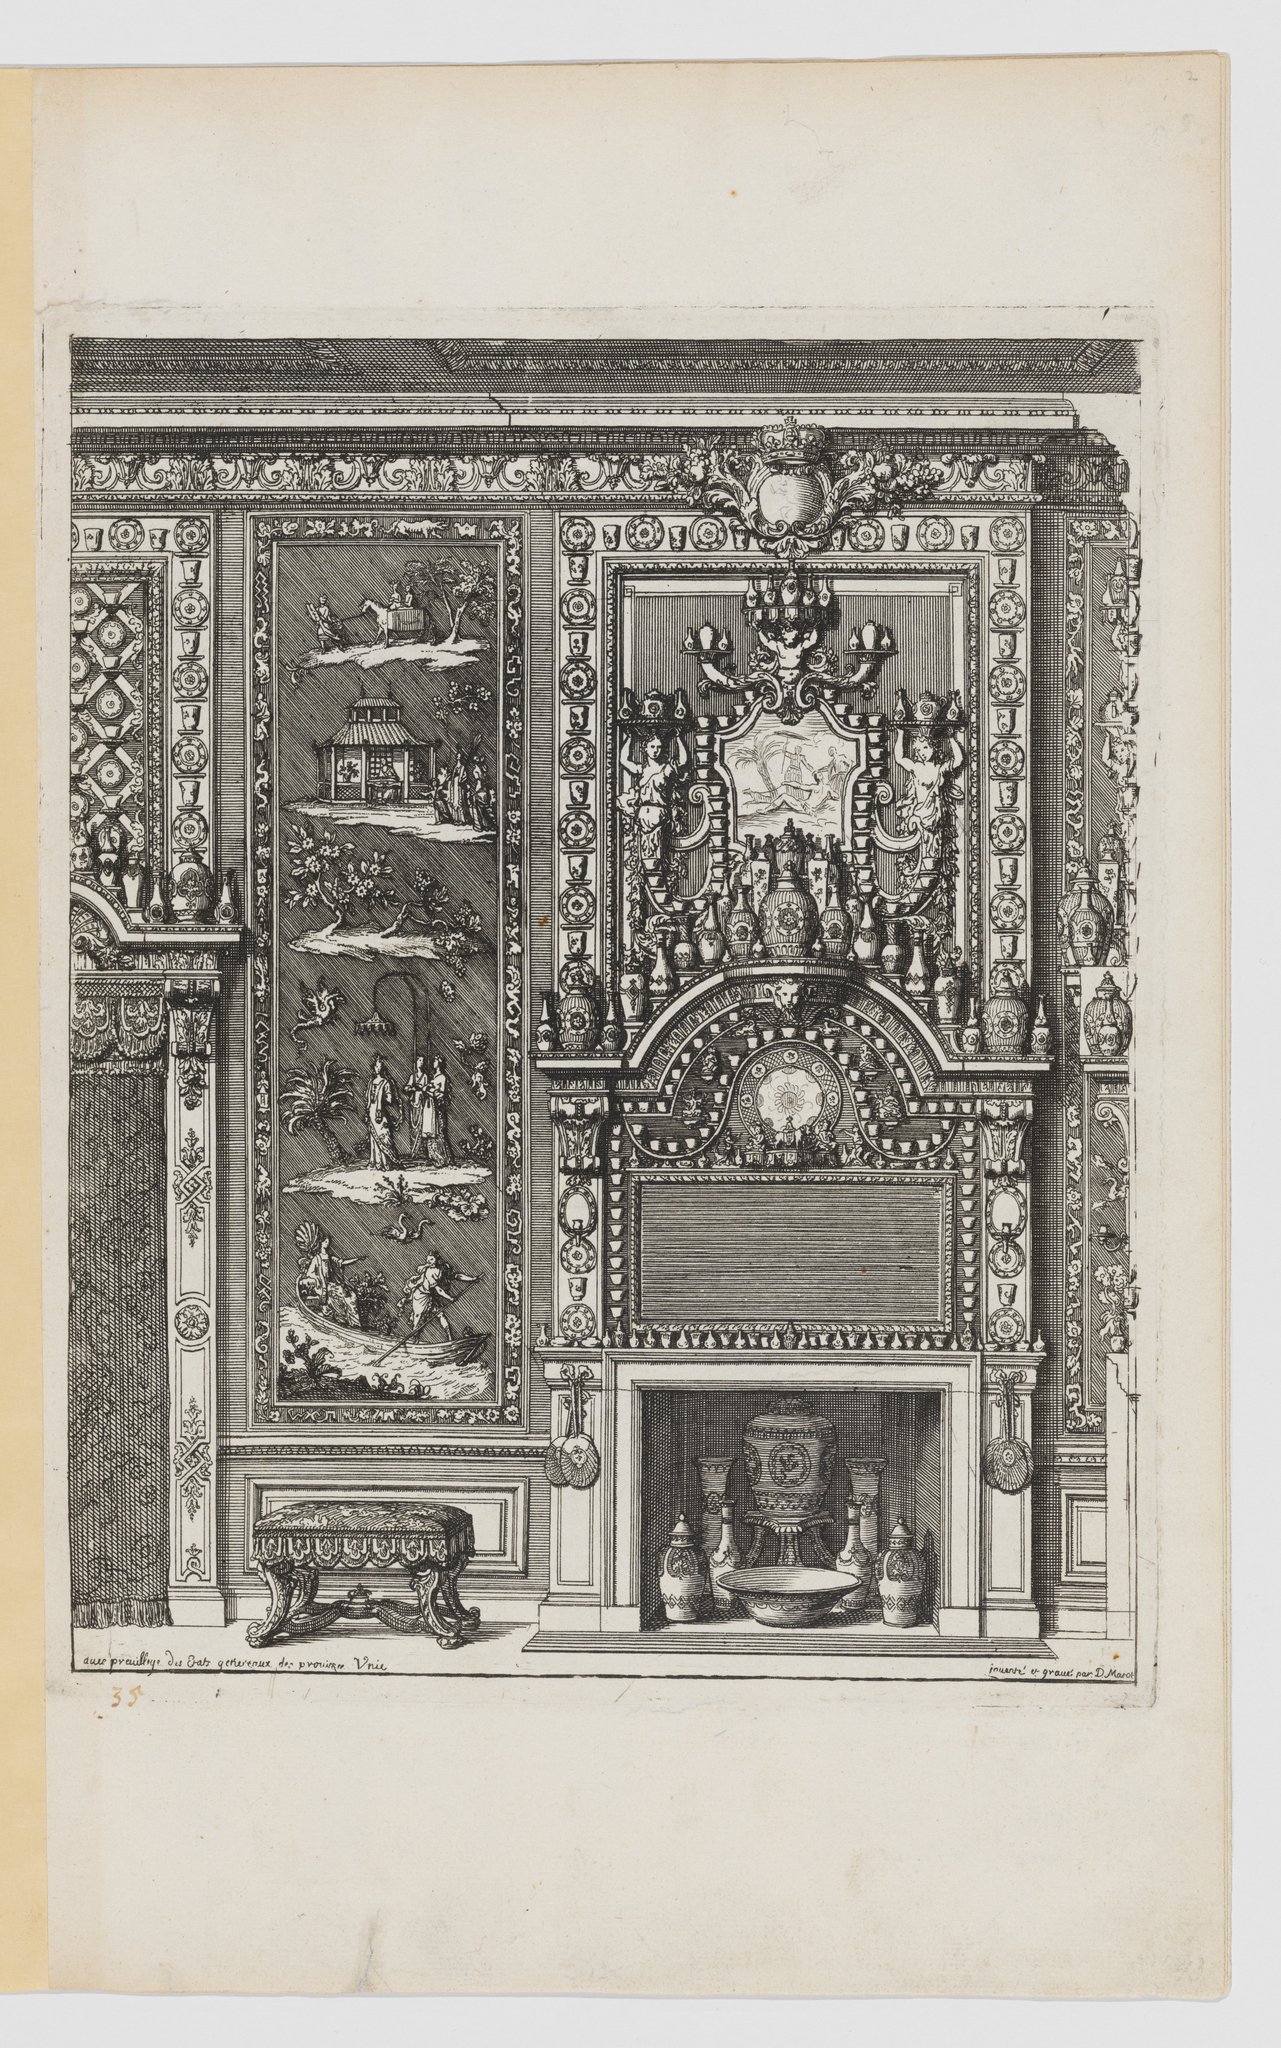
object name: print collection ornament architecture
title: Chimney-Piece with Various Porcelain Vases, from Nouvelles Cheminées Faittes en Plusieur en Droits de la Hollande et Autres Prouinces, part of Œuvres du Sr. D. Marot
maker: daniel marot the elder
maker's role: artist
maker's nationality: french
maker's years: 1661-1752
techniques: etching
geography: netherlands